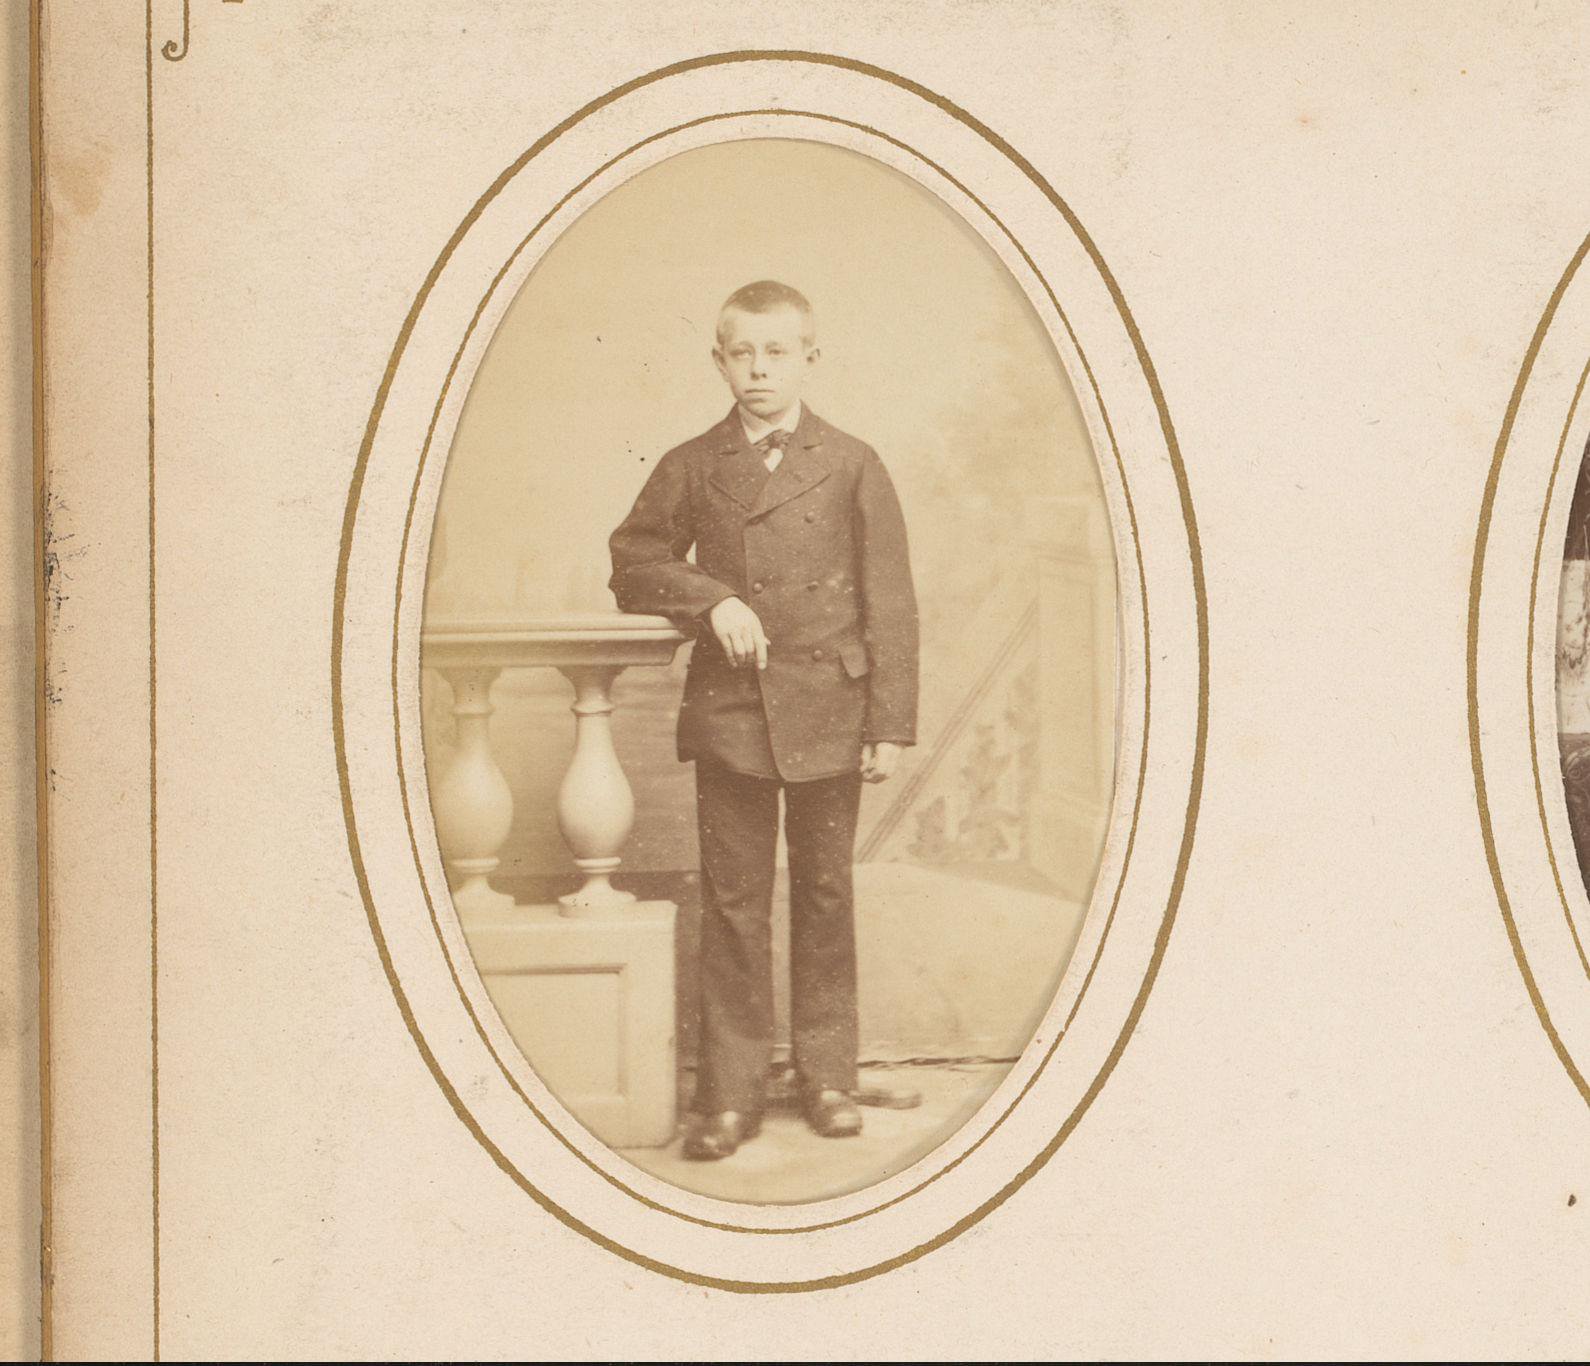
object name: photograph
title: Portret van een jongen, staand bij een balustrade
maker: eugene guérin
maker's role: fotograaf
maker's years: 1845-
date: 1875-1885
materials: cardboard, photographic support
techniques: albumen print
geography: brussels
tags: boy (child between toddler and youth), historical persons, balustrade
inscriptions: inscription: ‘Eug. Guérin - 142, Rue Royale/ BRUXELLES’